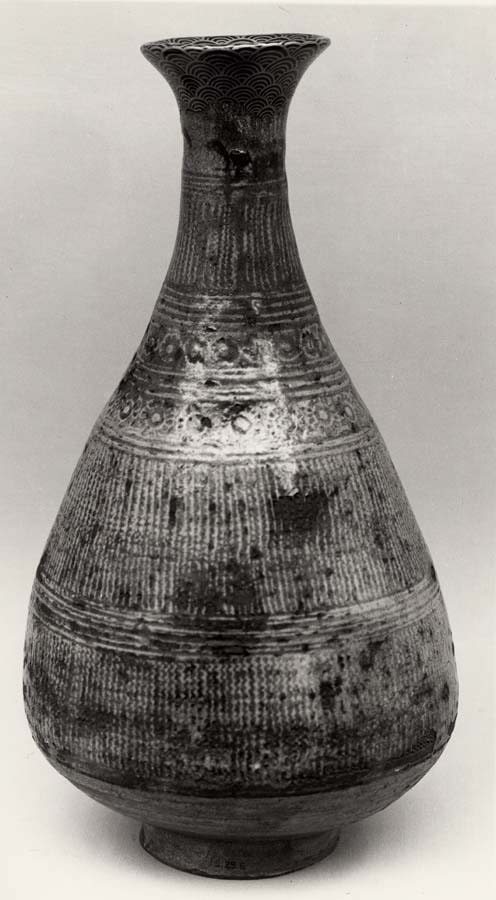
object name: bottle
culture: korean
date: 1901-1933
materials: glaze, stoneware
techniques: stamping